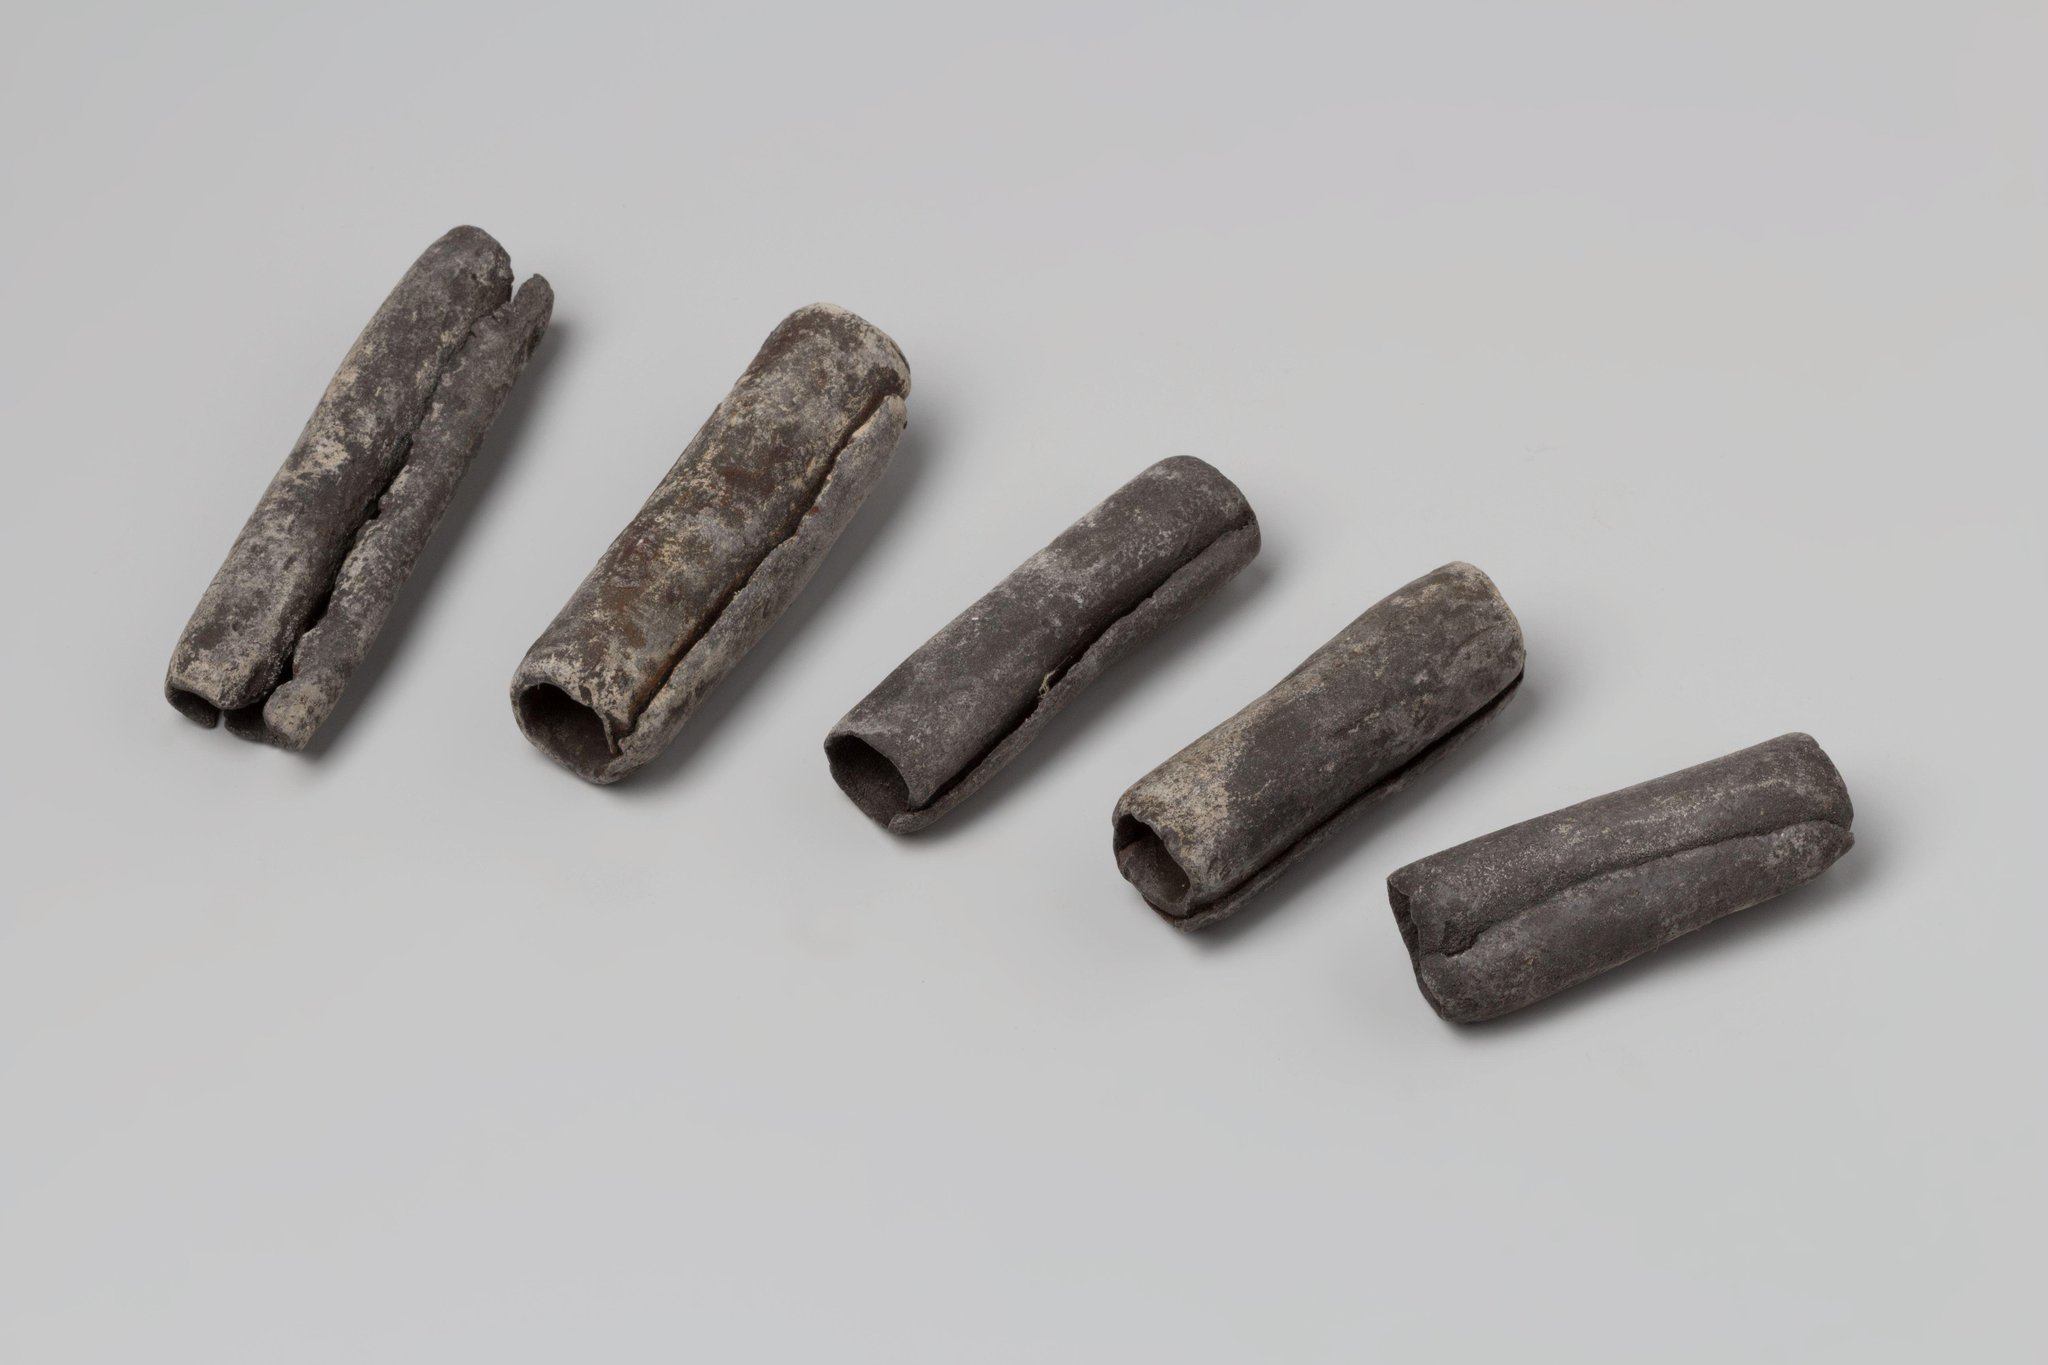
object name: lead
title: Loden rol uit het wrak van de Oost-Indiëvaarder 't Vliegend Hart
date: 1700-1735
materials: lead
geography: middelburg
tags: 't vliegend hart (schip), verenigde oostindische compagnie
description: Deze loden buisjes zijn vermoedelijk afkomstig van visnetten ofwel op TVliegend Hart zelf ofwel van vissers die hun netten aan het wrak verloren.